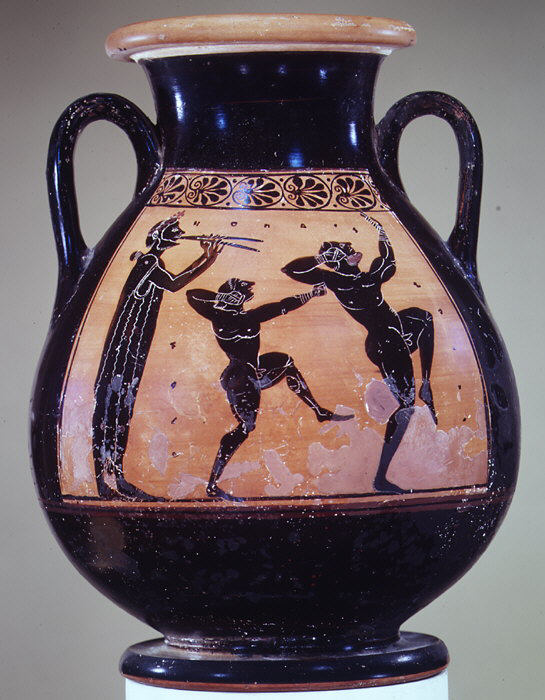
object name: pelike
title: Terracotta pelike (wine jar)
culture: greek, attic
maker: acheloös painter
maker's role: artist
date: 510 BCE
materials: terracotta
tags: men,boxing,flutes,midas,athletes,musicians